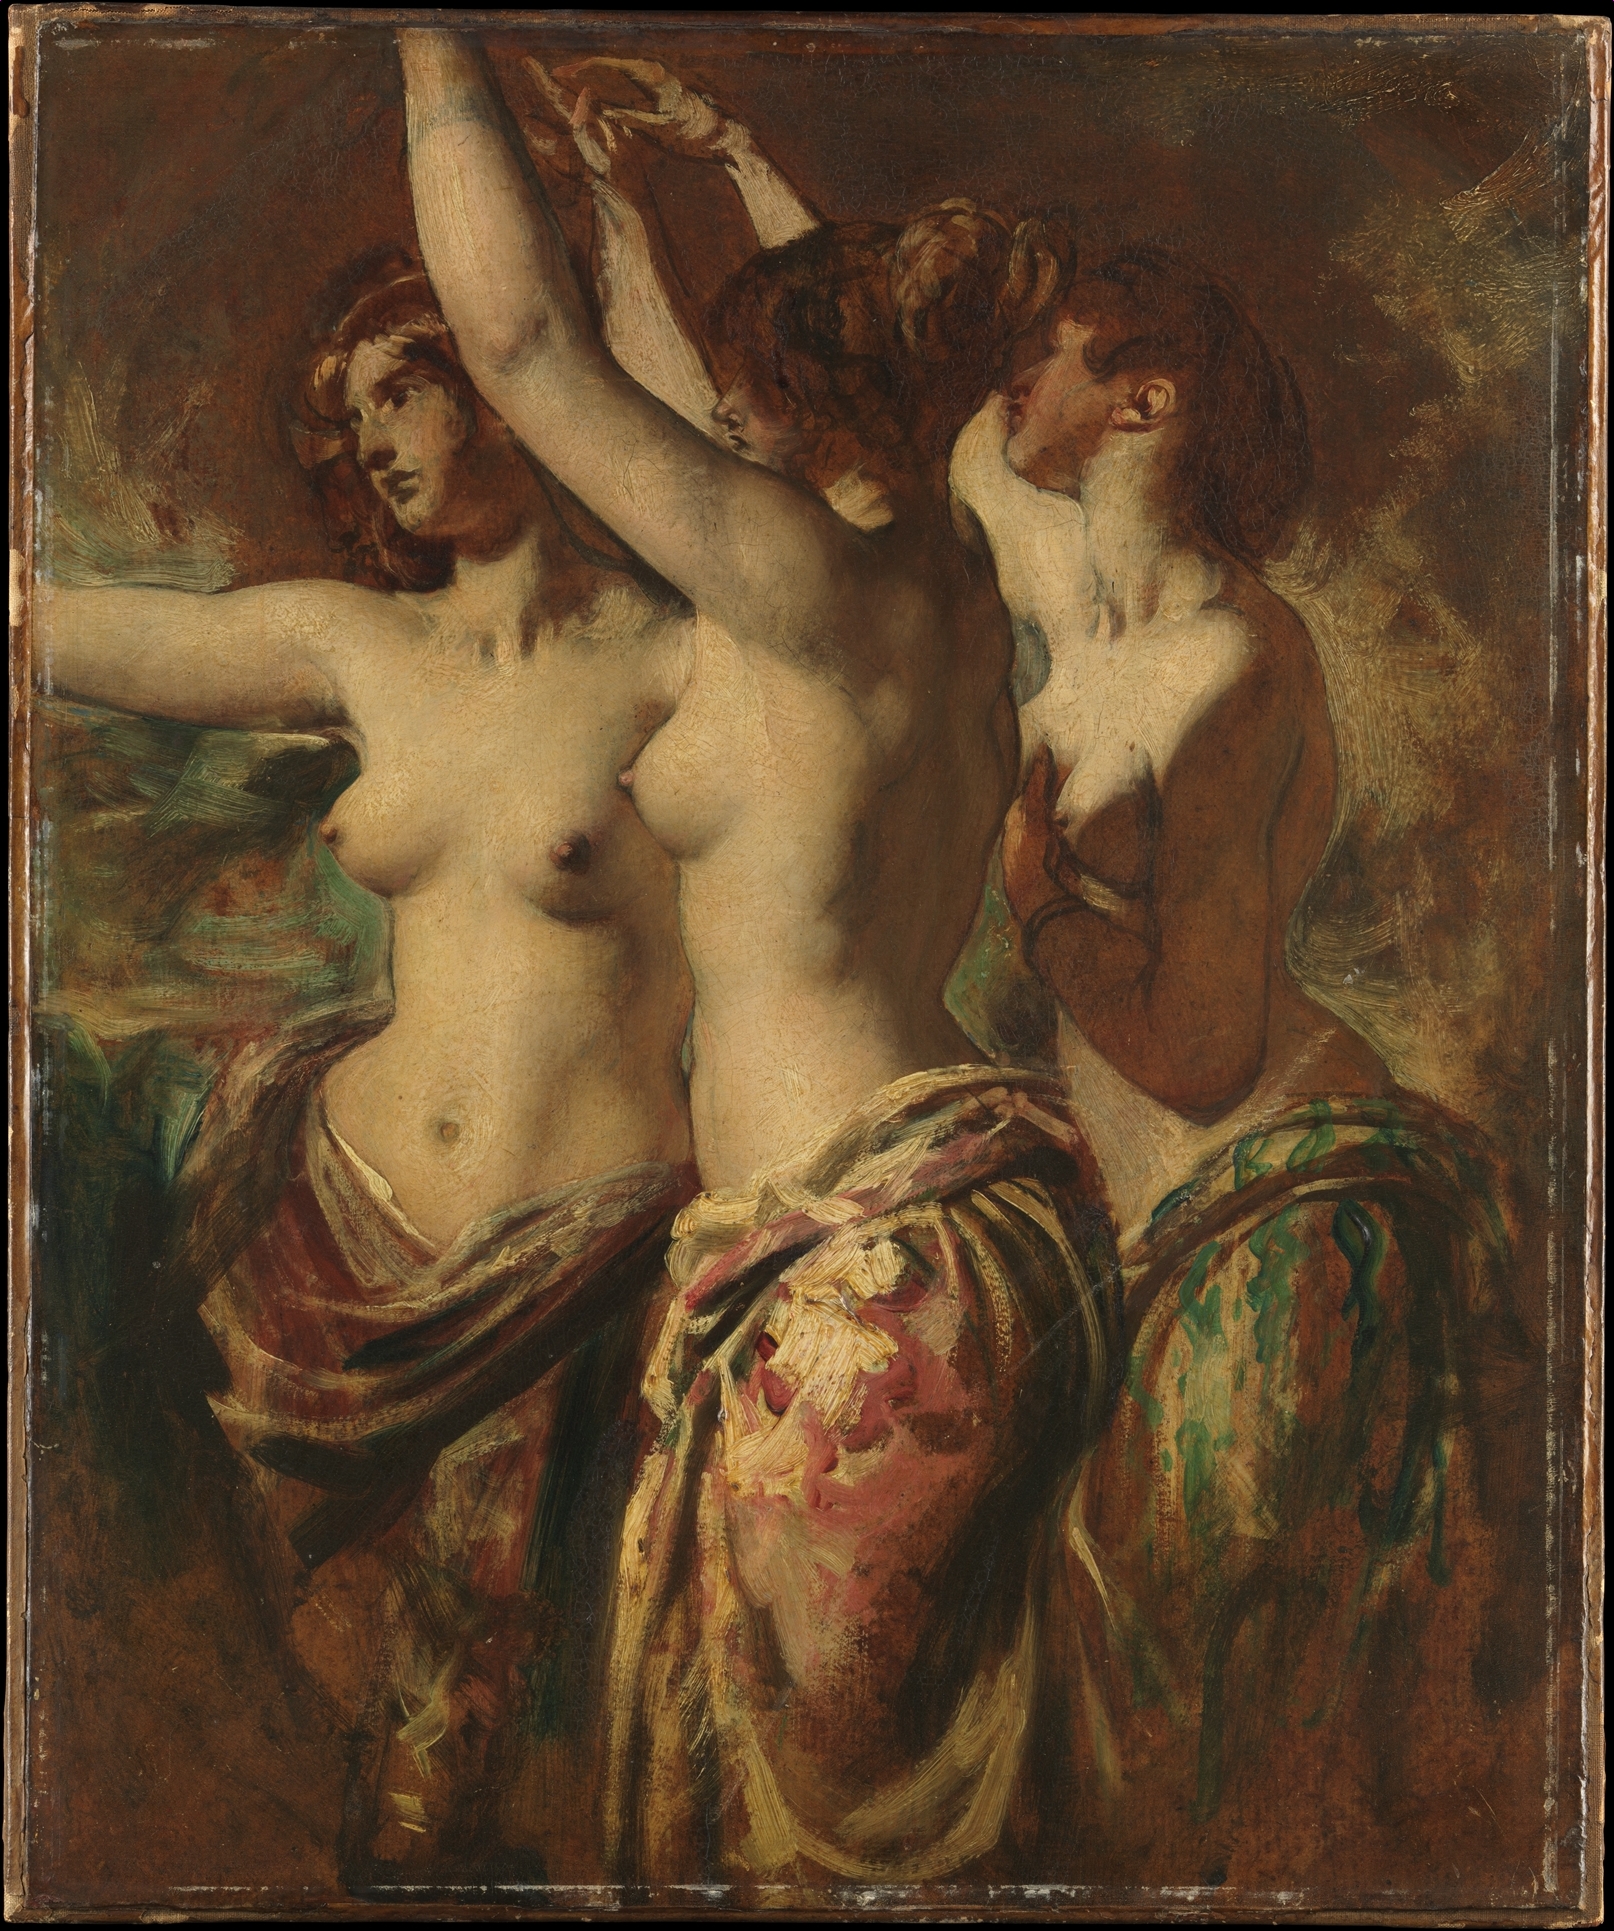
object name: painting, sketch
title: The Three Graces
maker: william etty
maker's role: artist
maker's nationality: british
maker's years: 1787-1849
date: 1807-1849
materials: oil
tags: female nudes,greek mythology